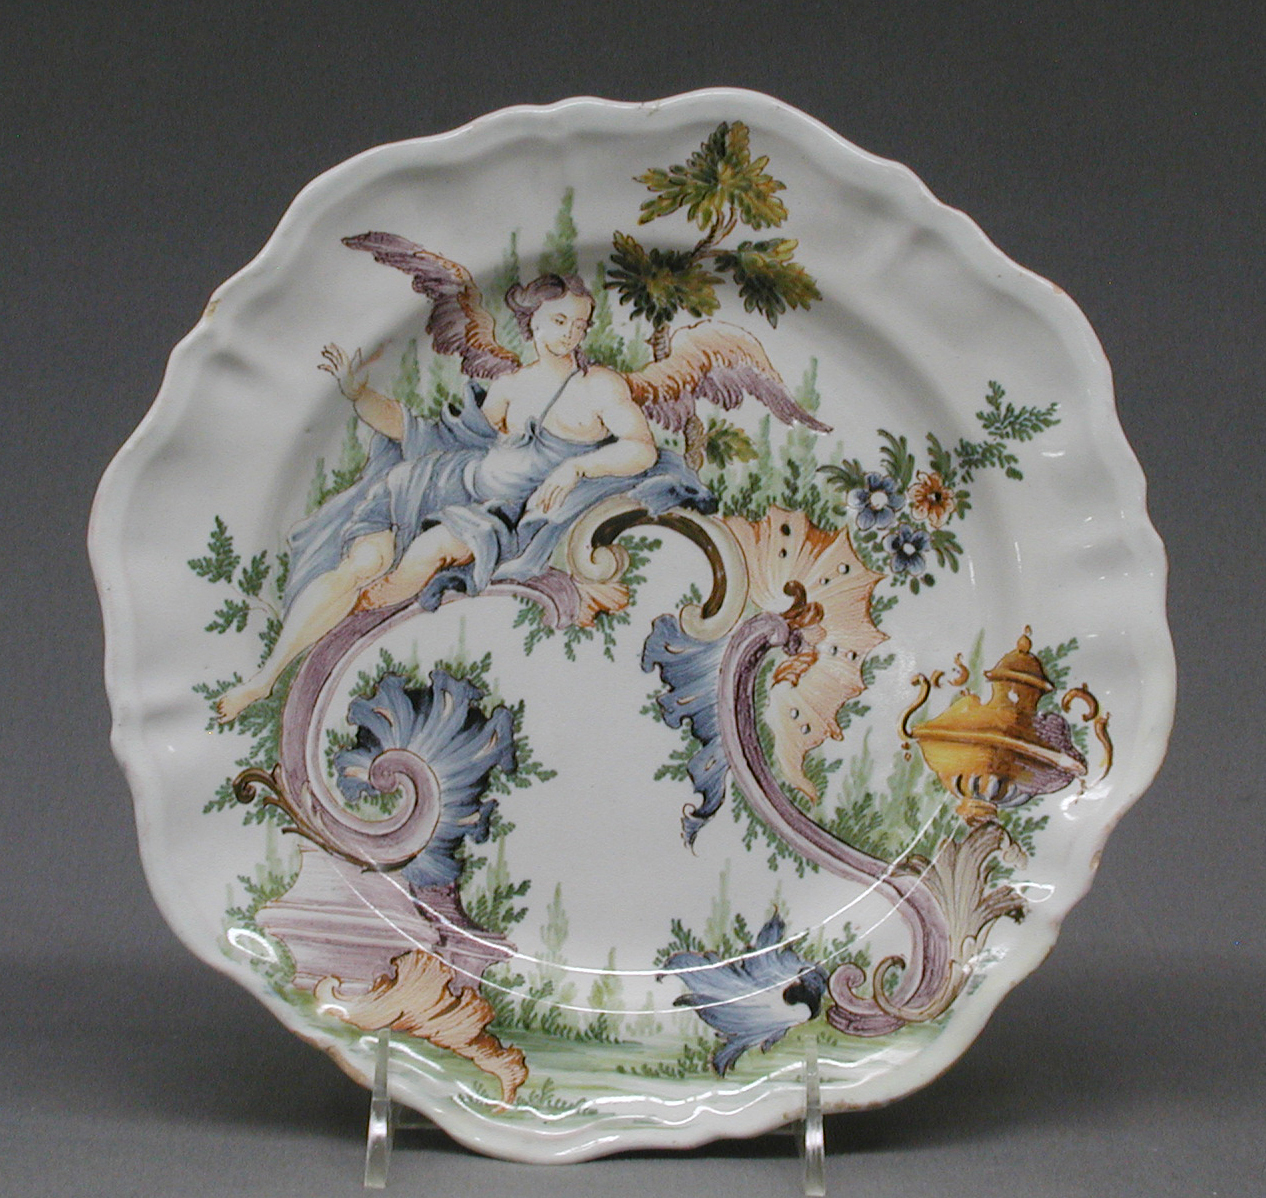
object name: plate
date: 1770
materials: faience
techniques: glazing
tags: angels